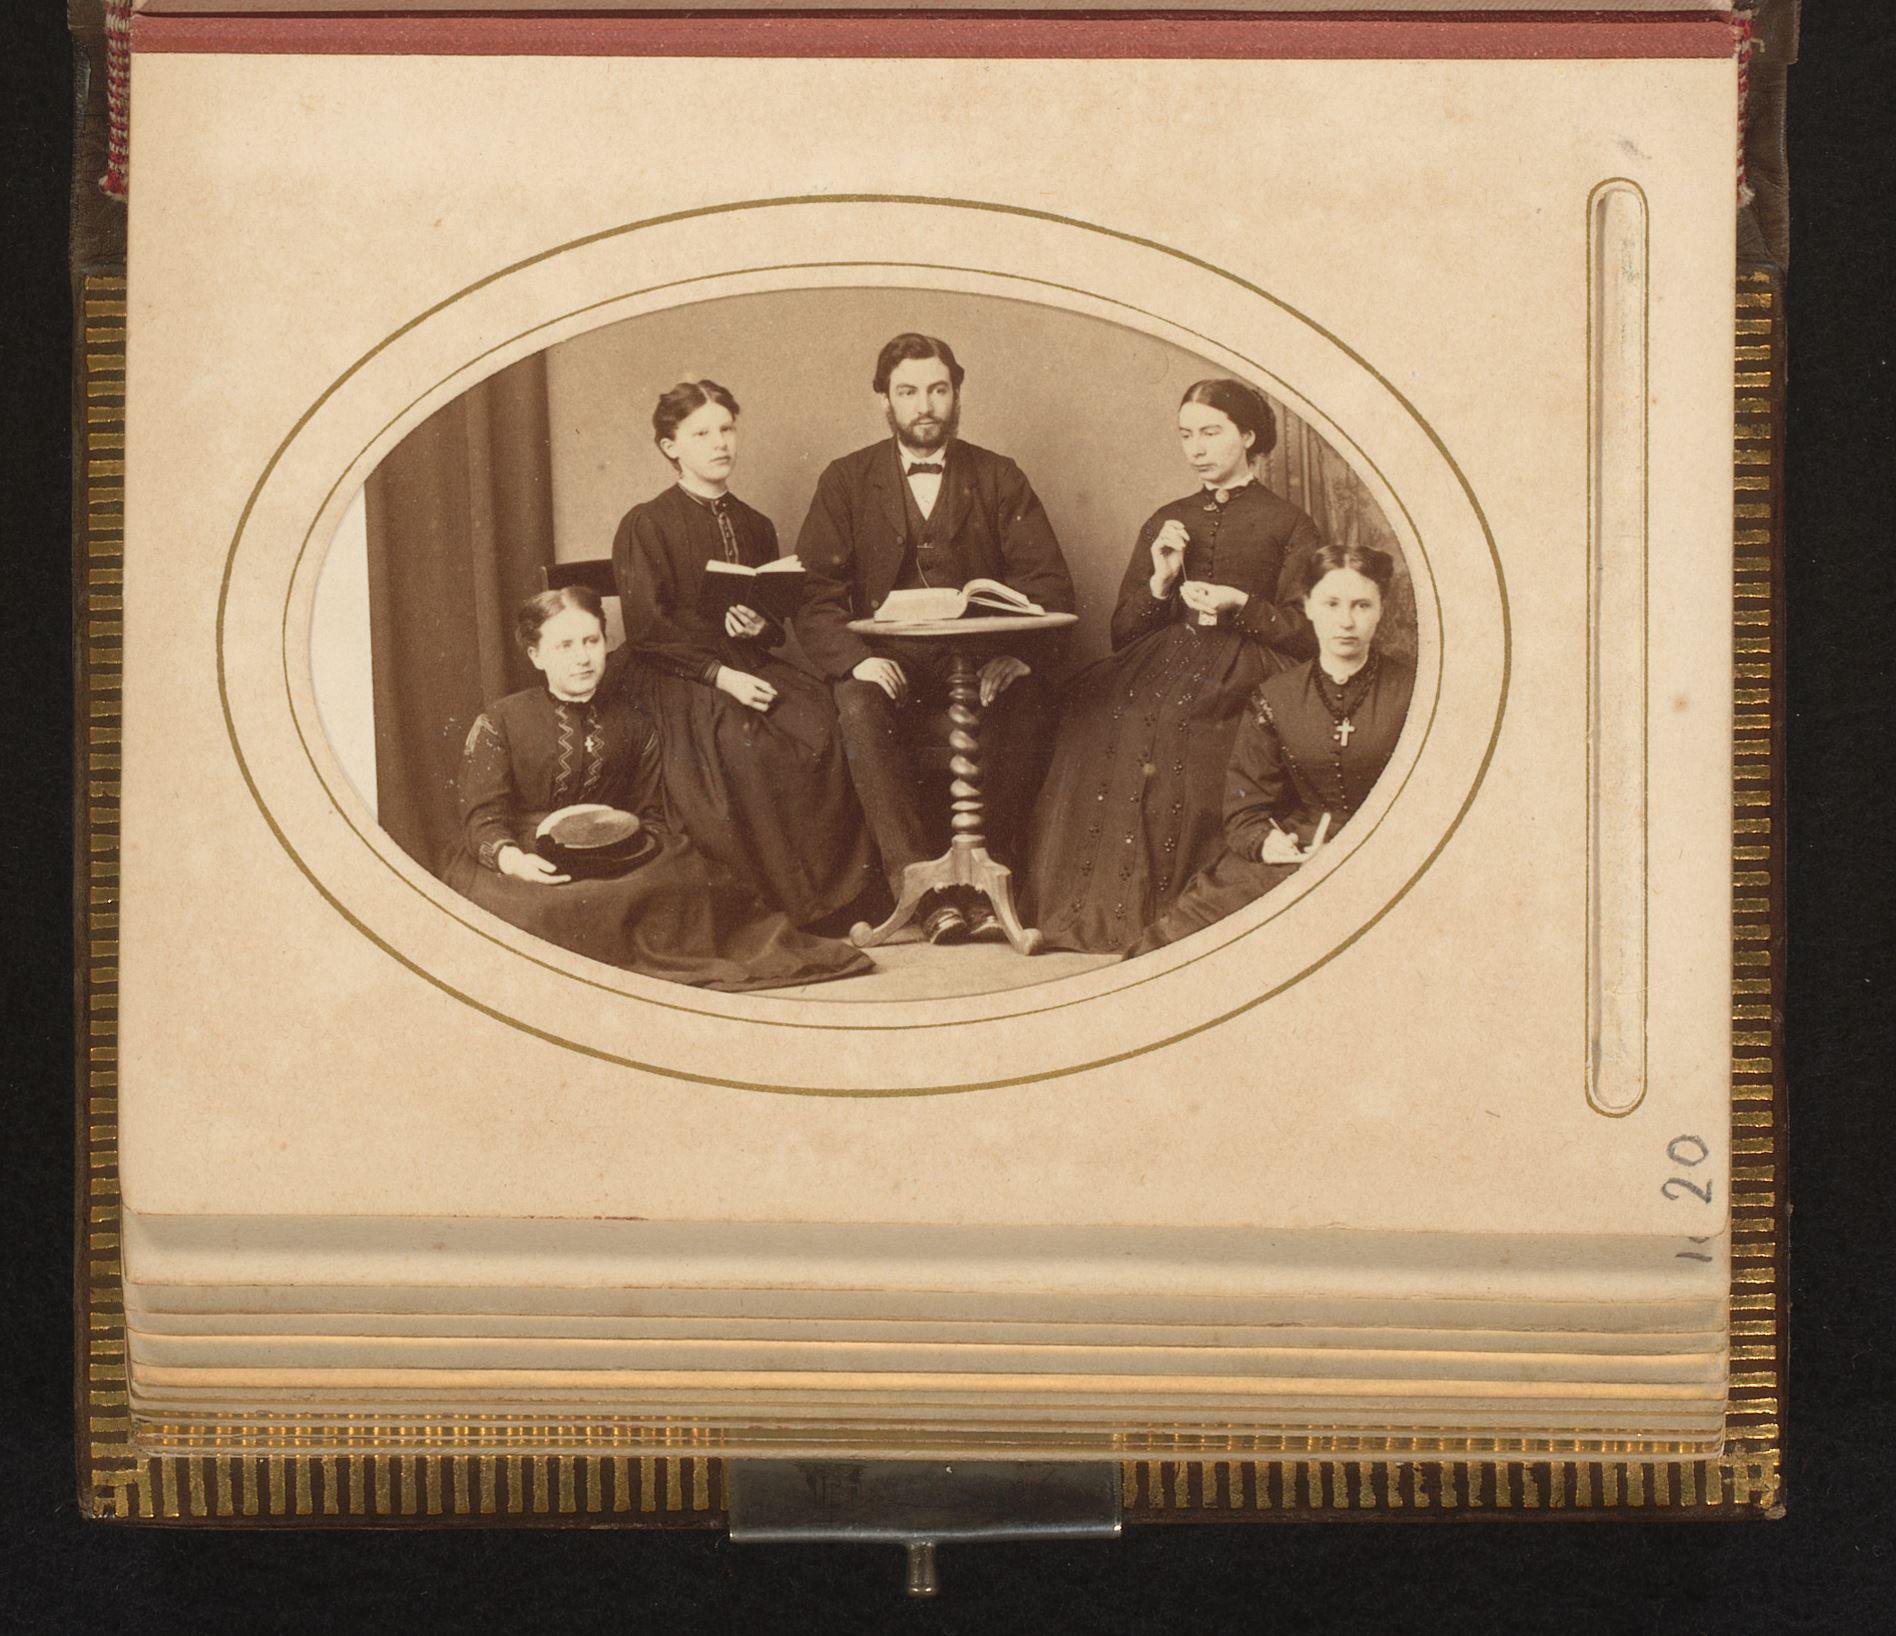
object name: album leaf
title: Portret van een man en vier vrouwen rondom een tafel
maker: Anonymous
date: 1860-1885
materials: cardboard, paper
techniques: albumen print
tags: reading, historical persons - bb - woman, adult man, historical persons, (other forms of) needlework, e.g.: crocheting, knitting, embroidering